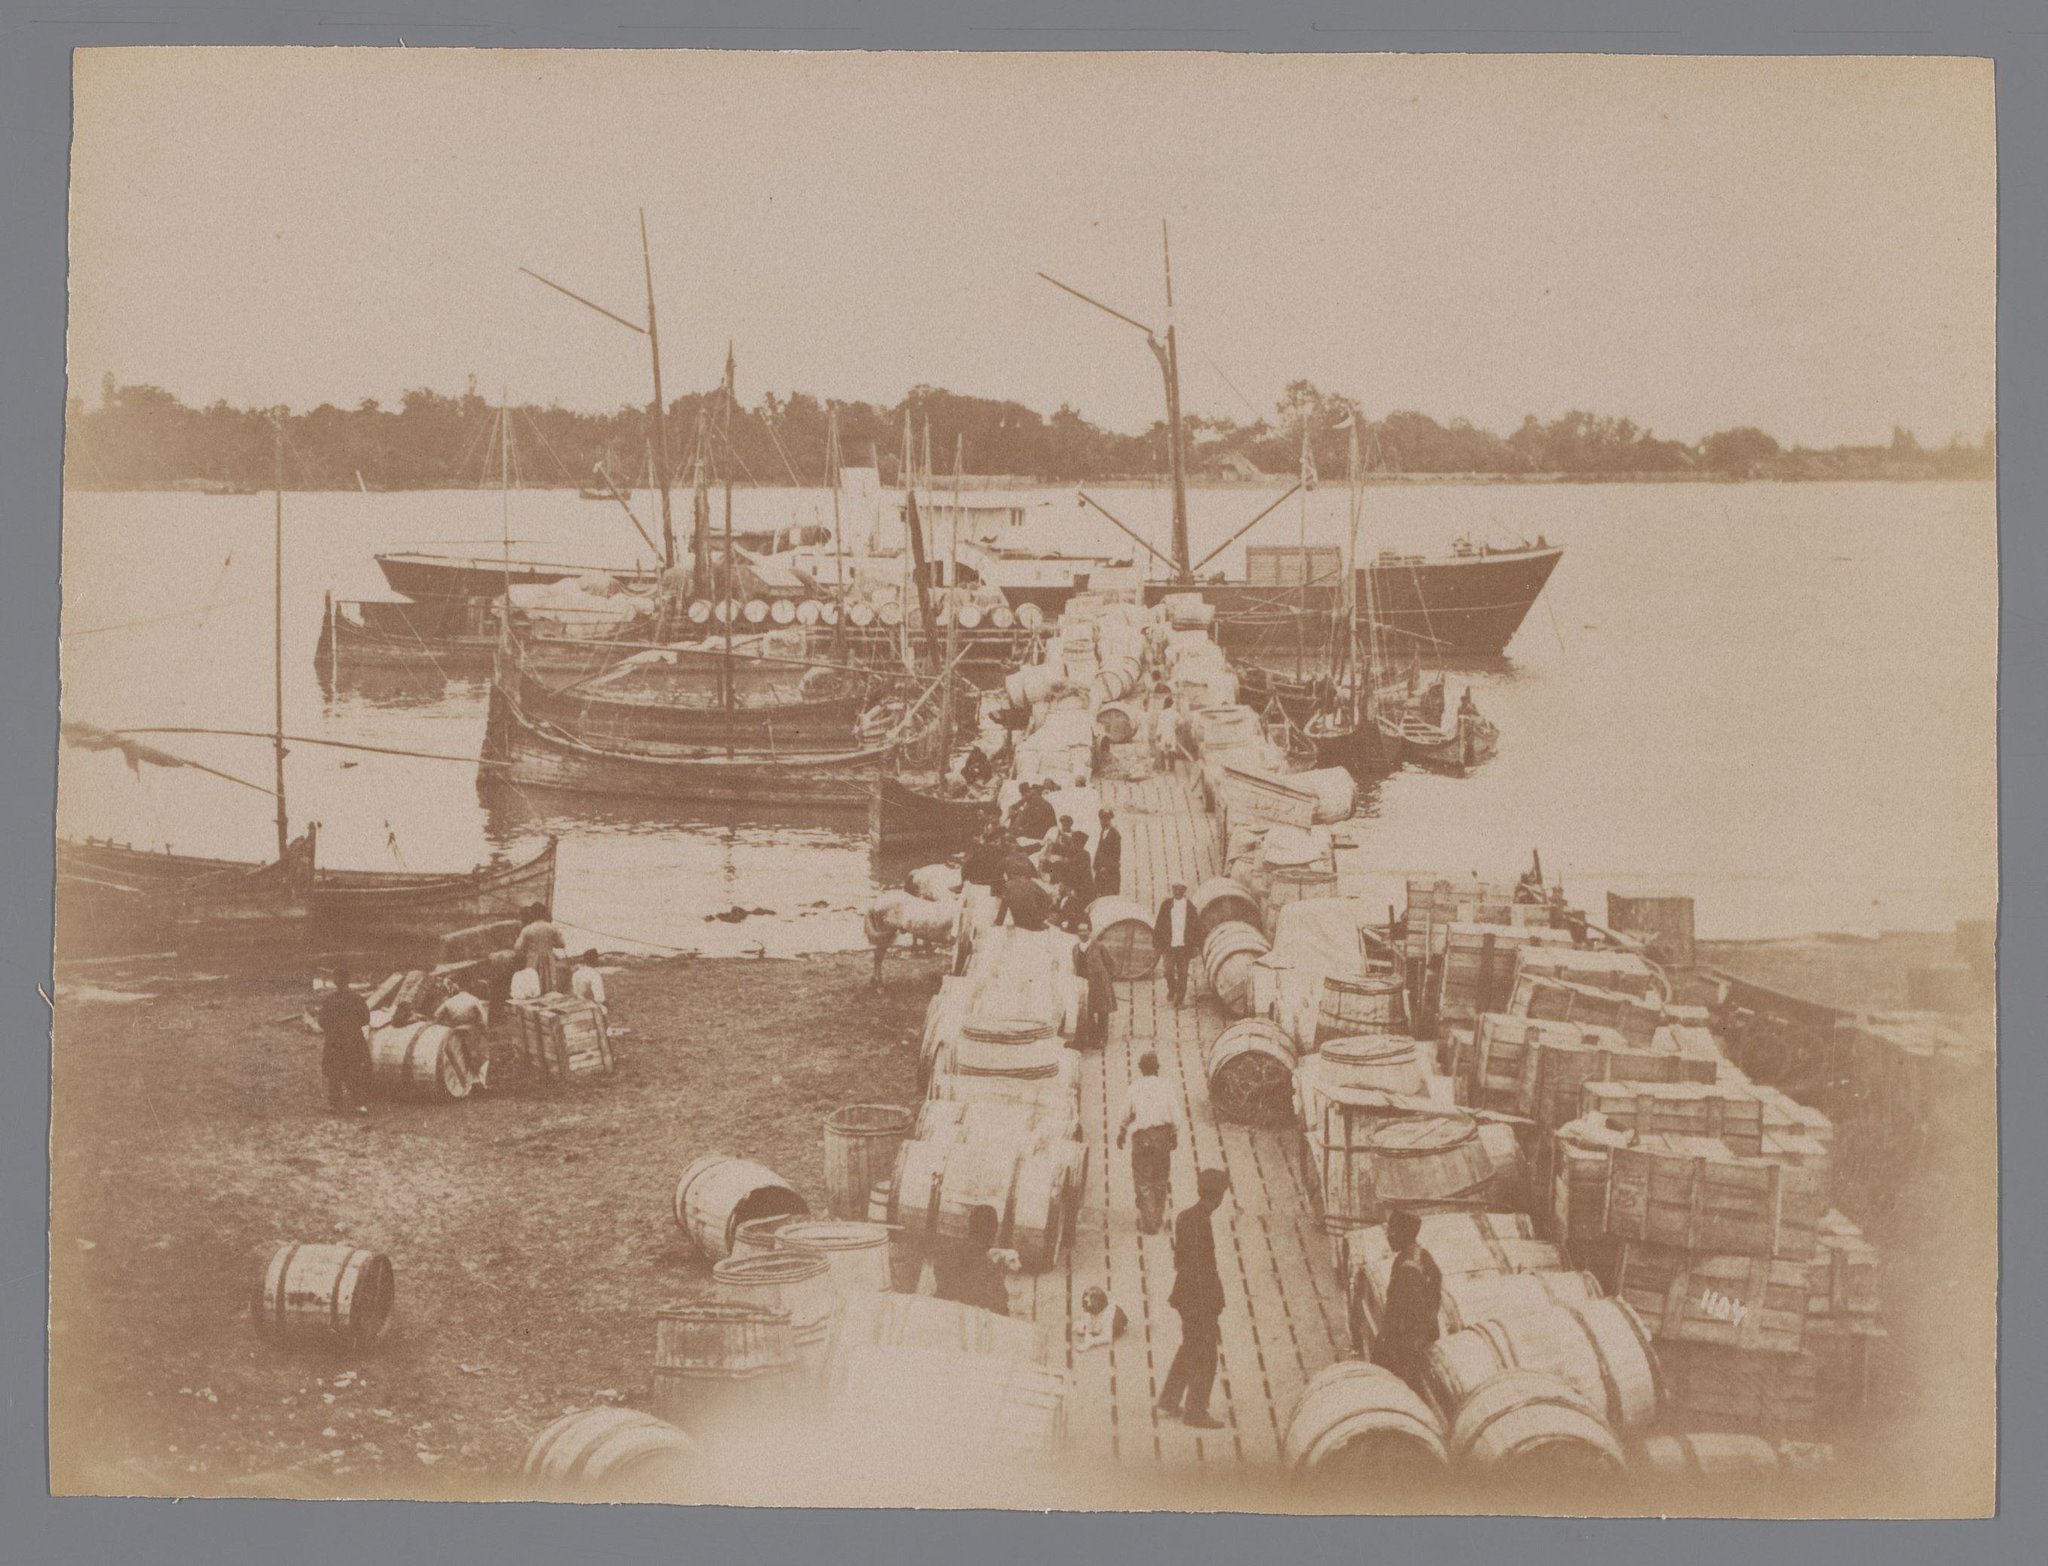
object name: photograph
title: Haven, in-/uitladen van schepen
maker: antoine sevruguin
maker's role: fotograaf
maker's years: 1840-1933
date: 1880-1910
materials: paper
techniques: albumen print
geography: iran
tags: iran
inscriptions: number: ‘2.’, number: ‘1104’, inscription: ‘Eingelé [?]’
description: Haven, in-/uitladen van schepen, Iran. Steiger met vaten en pakketten en mannen die aan het werk zijn. Expeditie?